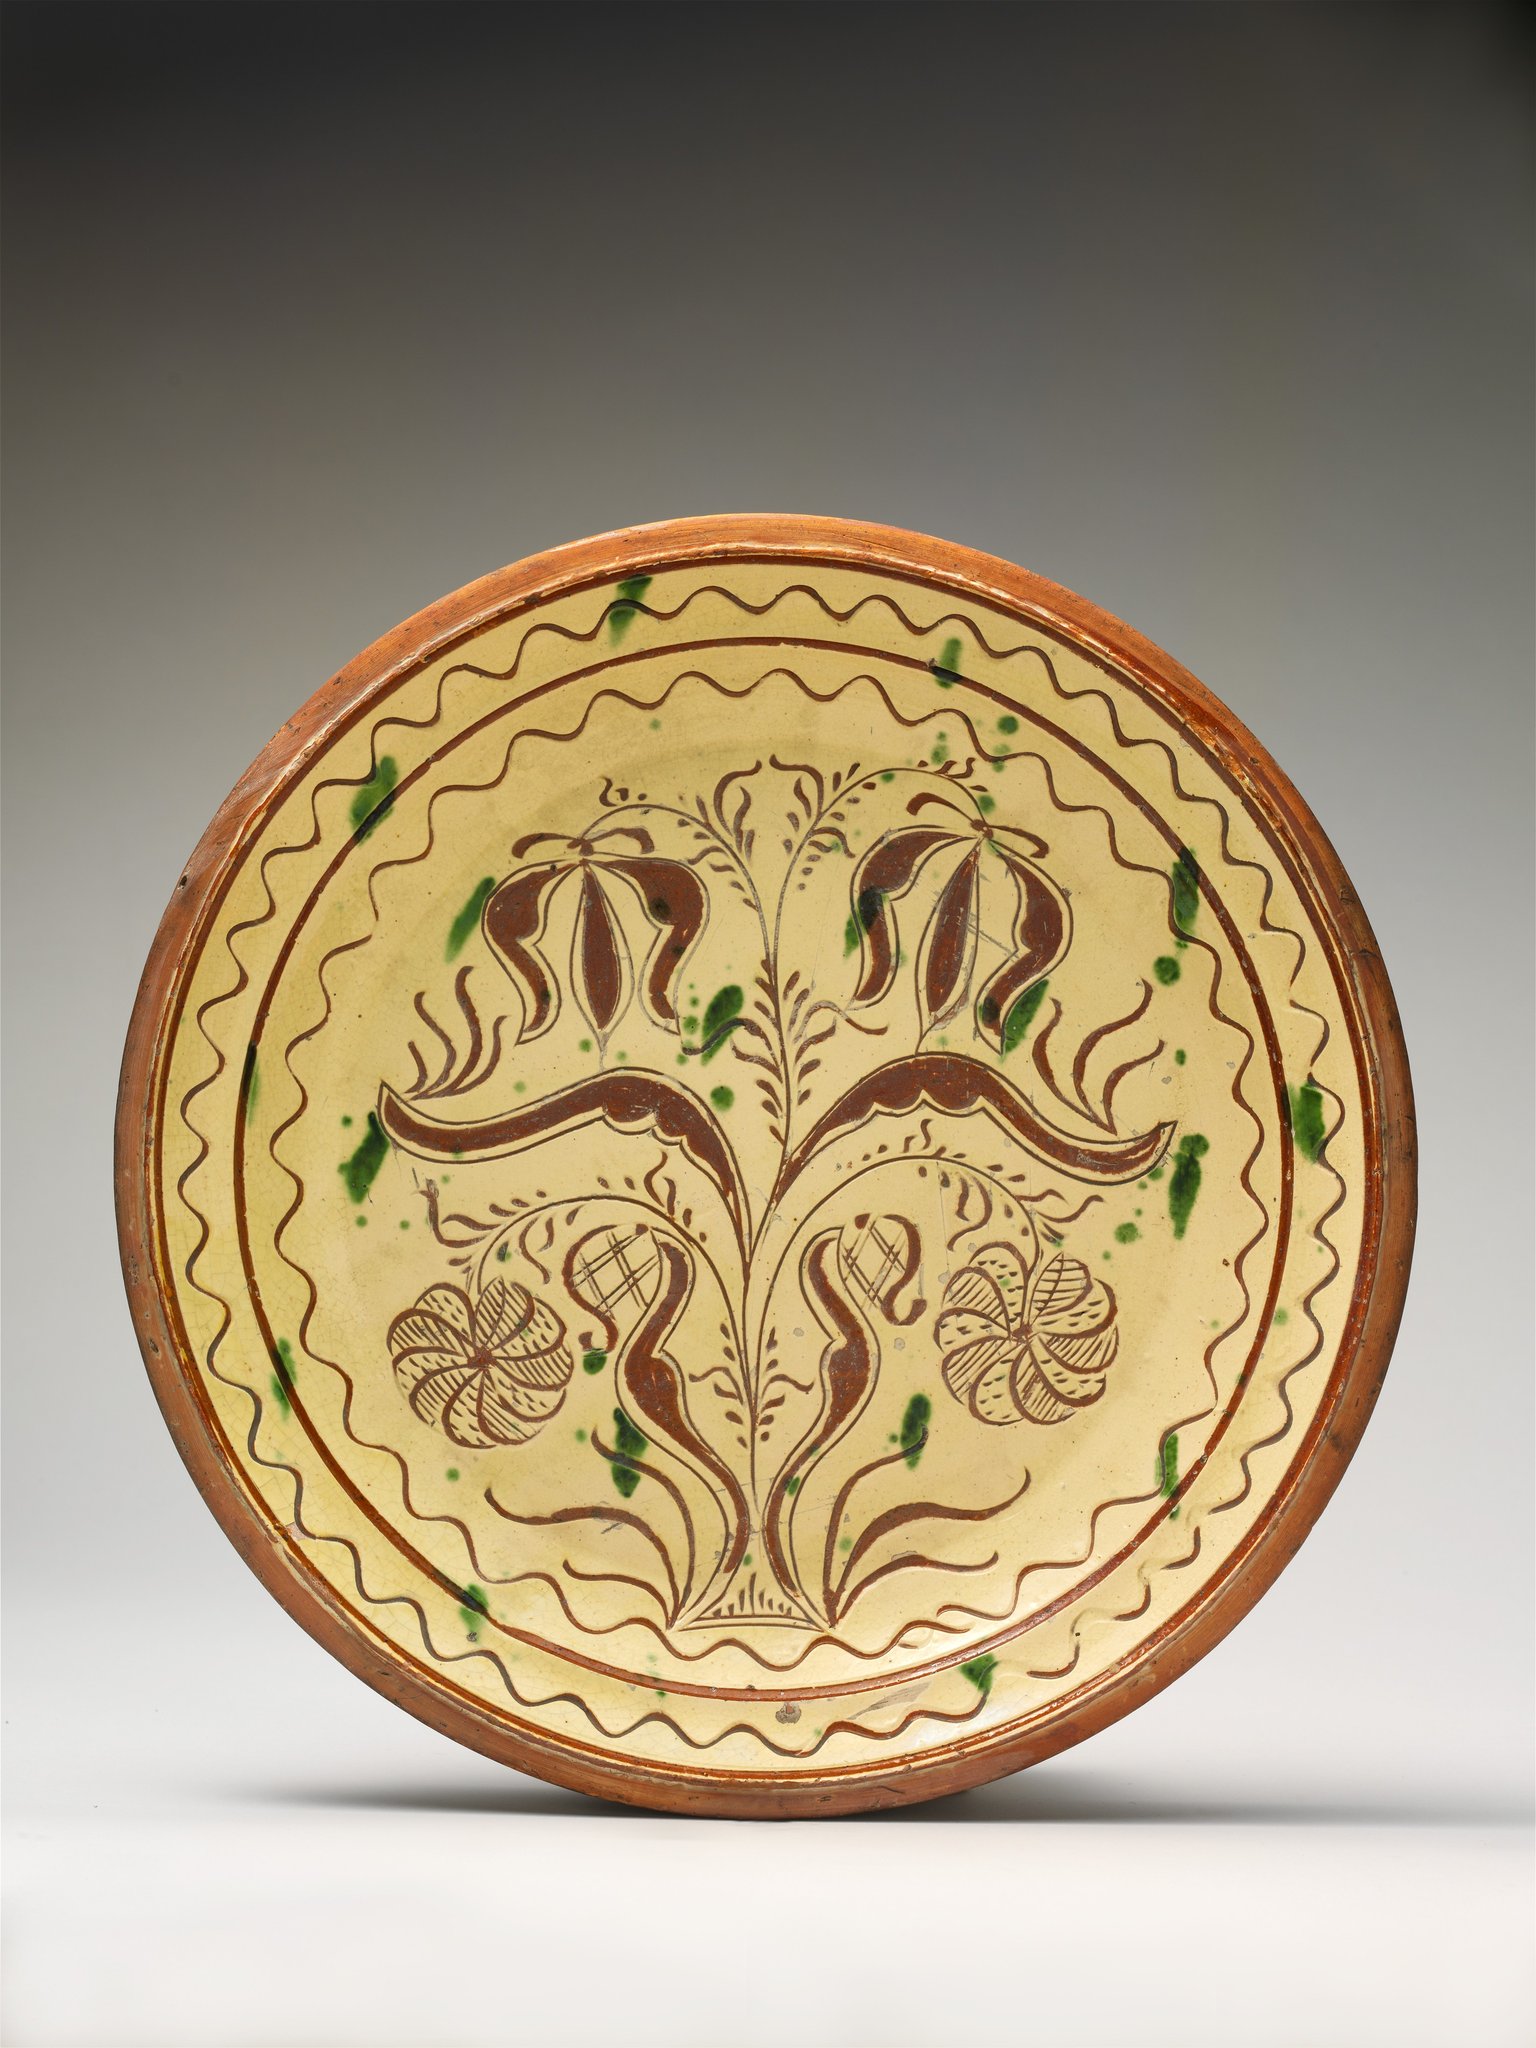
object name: plate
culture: american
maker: conrad mumbouer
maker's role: maker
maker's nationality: american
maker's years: 1761-1845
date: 1794-1844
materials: earthenware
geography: united states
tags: flowers